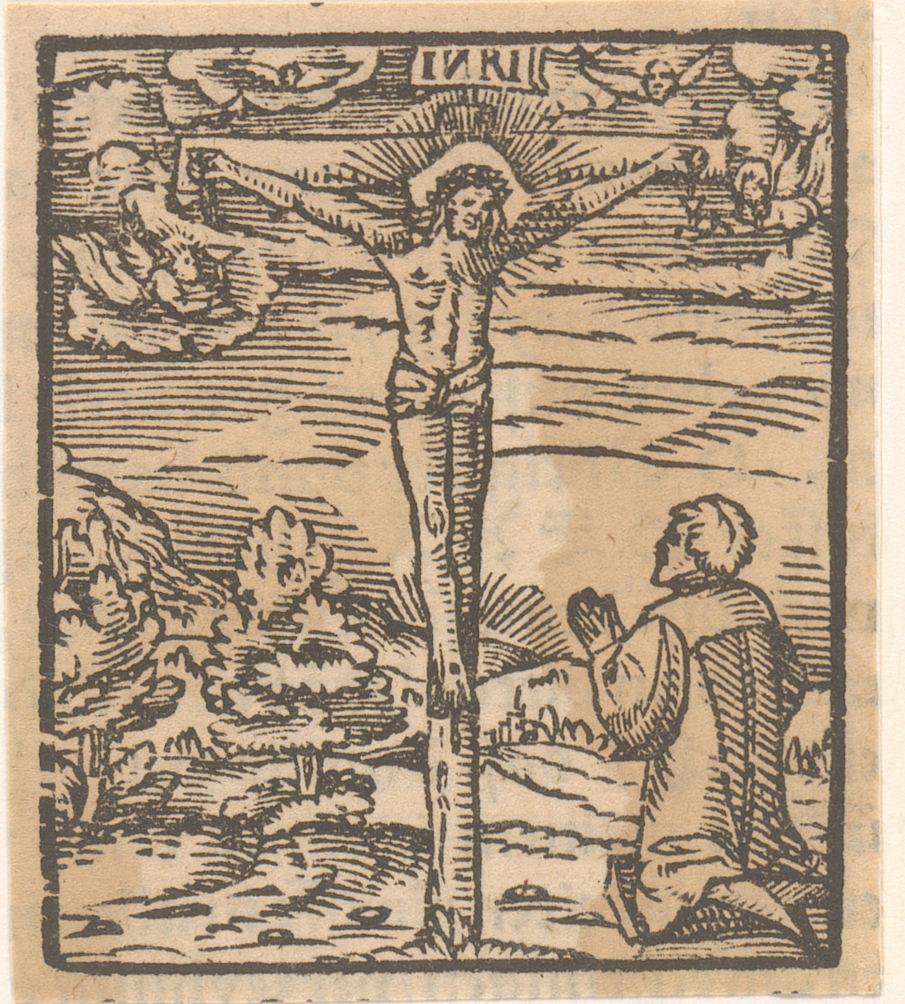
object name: print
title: Christus aan het kruis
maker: Anonymous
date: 1563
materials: paper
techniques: letterpress printing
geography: germany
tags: crucified christ with other persons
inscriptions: collector's mark: Lugt 2228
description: Prent uit: Canisius, Petrus. Catechismus: Kurtze Erclärung der fürnemsten stuck des wahren Catholischen form zu betten. S.l.s.n., 1563.